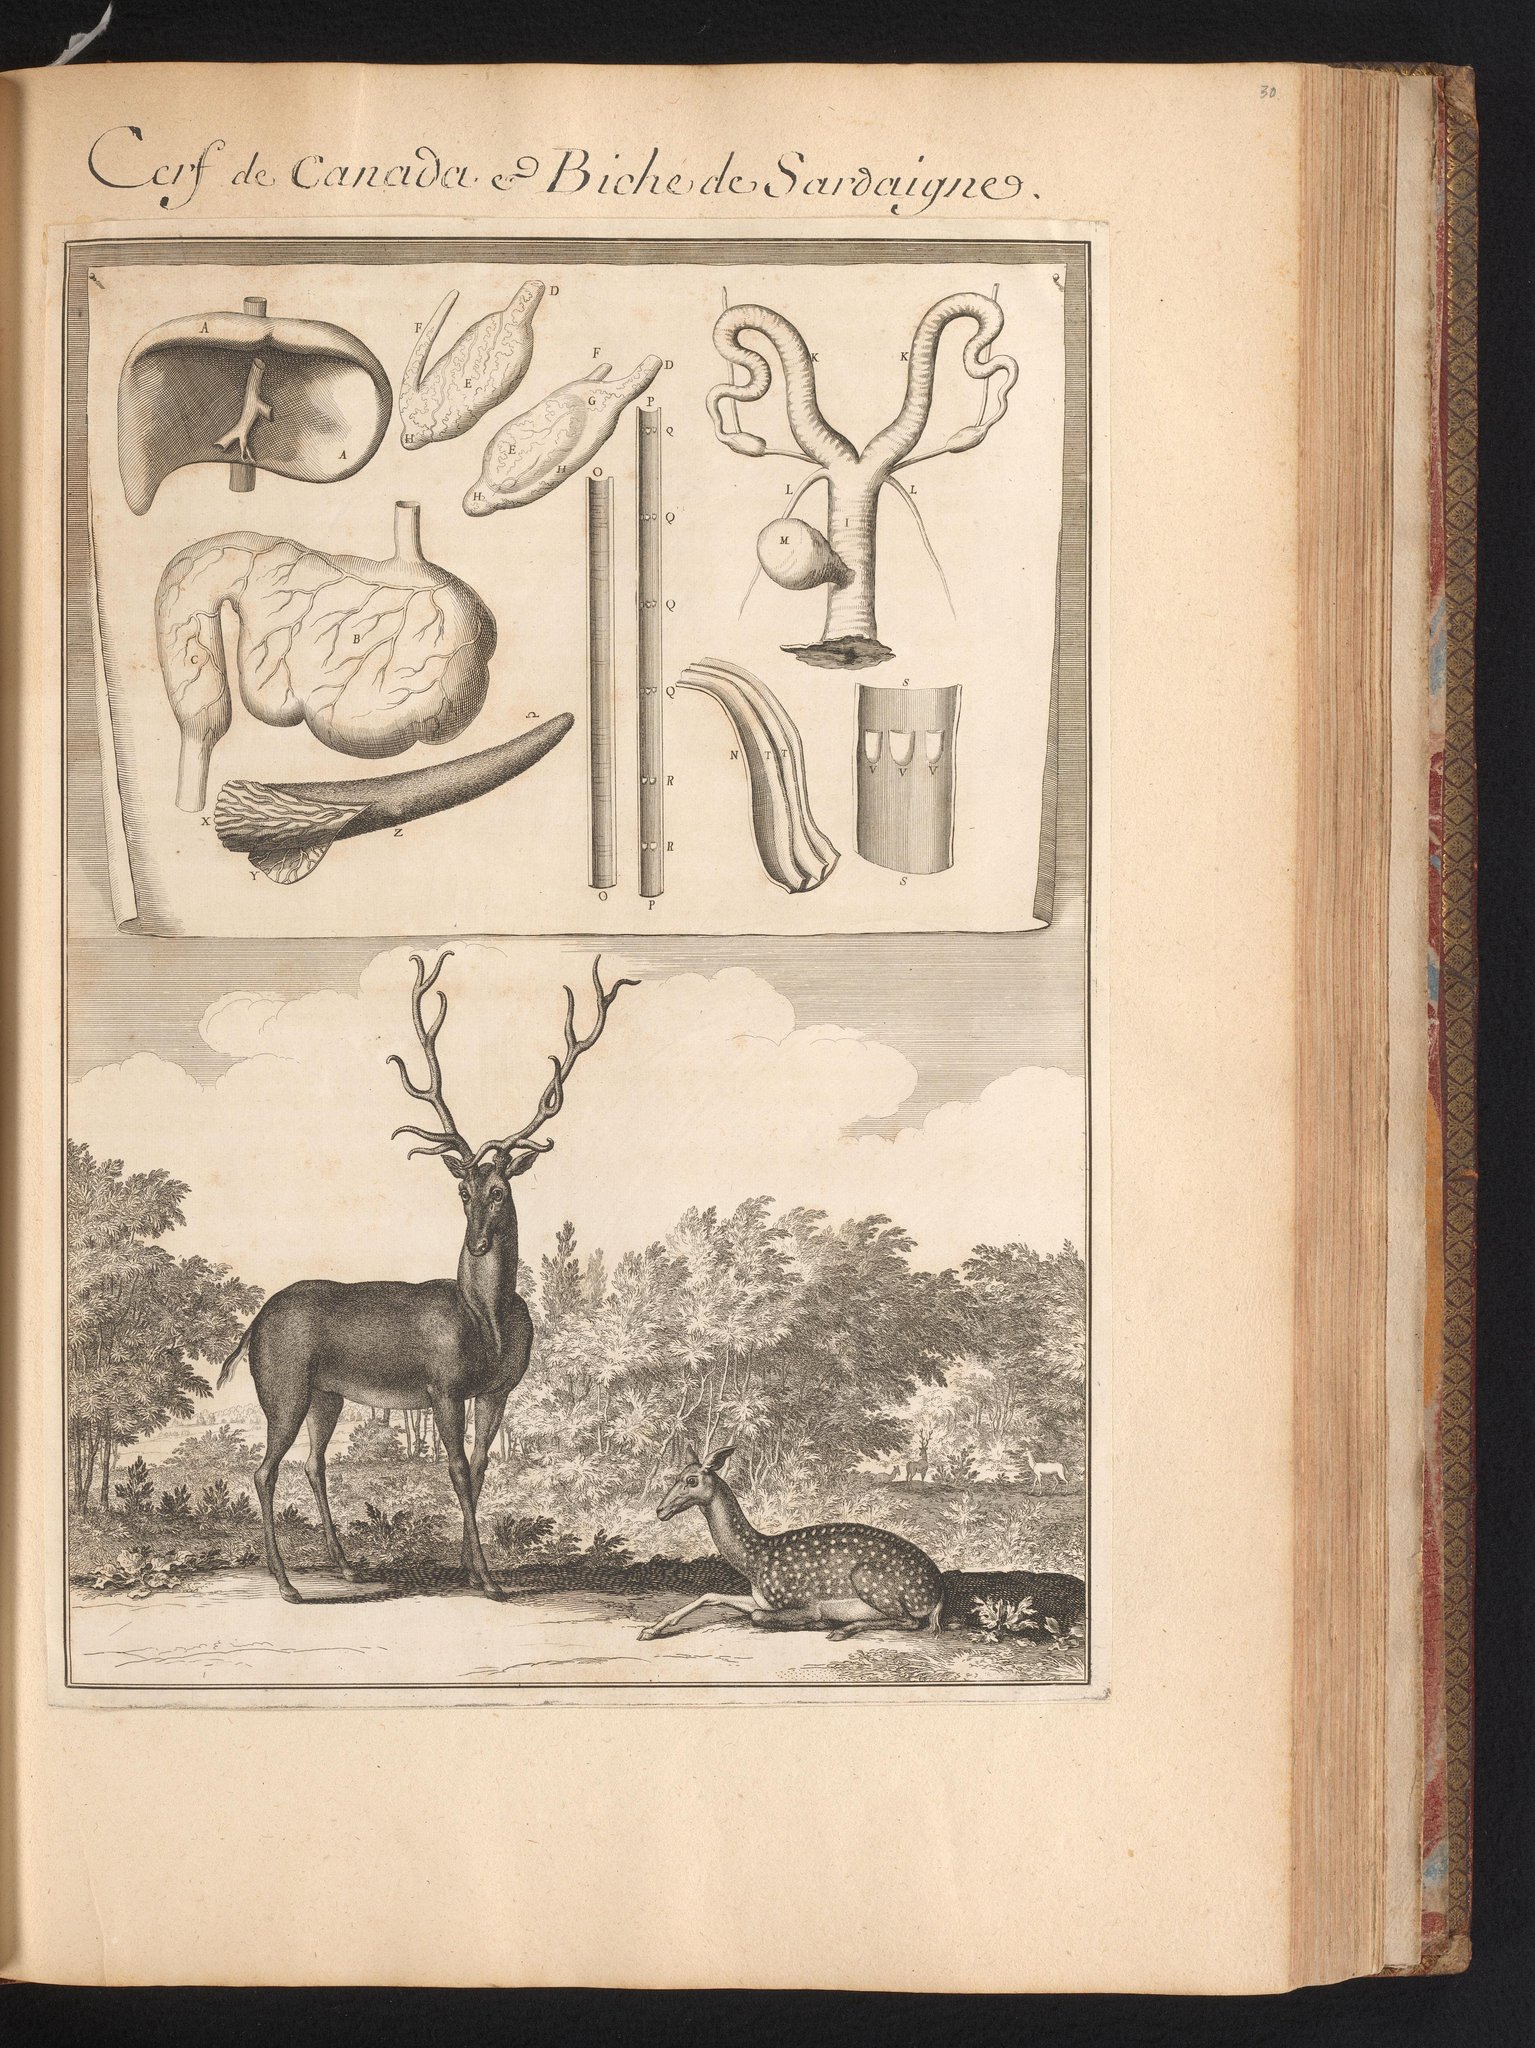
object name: album leaf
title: Canadees en Sardijns hert in een landschap met bovenaan op een blad de organen van het hert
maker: sébastien leclerc (i)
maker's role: print maker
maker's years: 1637-1714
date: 1676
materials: ink, paper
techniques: engraving, etching, pen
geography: paris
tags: dissection, hoofed animals: deer, hoofed animals: stag, animals (+ anatomy of animals)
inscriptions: inscription: ‘Cerf de Canada & Biche de Sardaigne.’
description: Prent uit: Perrault, Claude. Mémoires pour servir à l'histoire naturelle des animaux. Dressez par M. Perrault de l'Académie Royale des Sciences (...). Parijs: Imprimerie Royale, 1676.